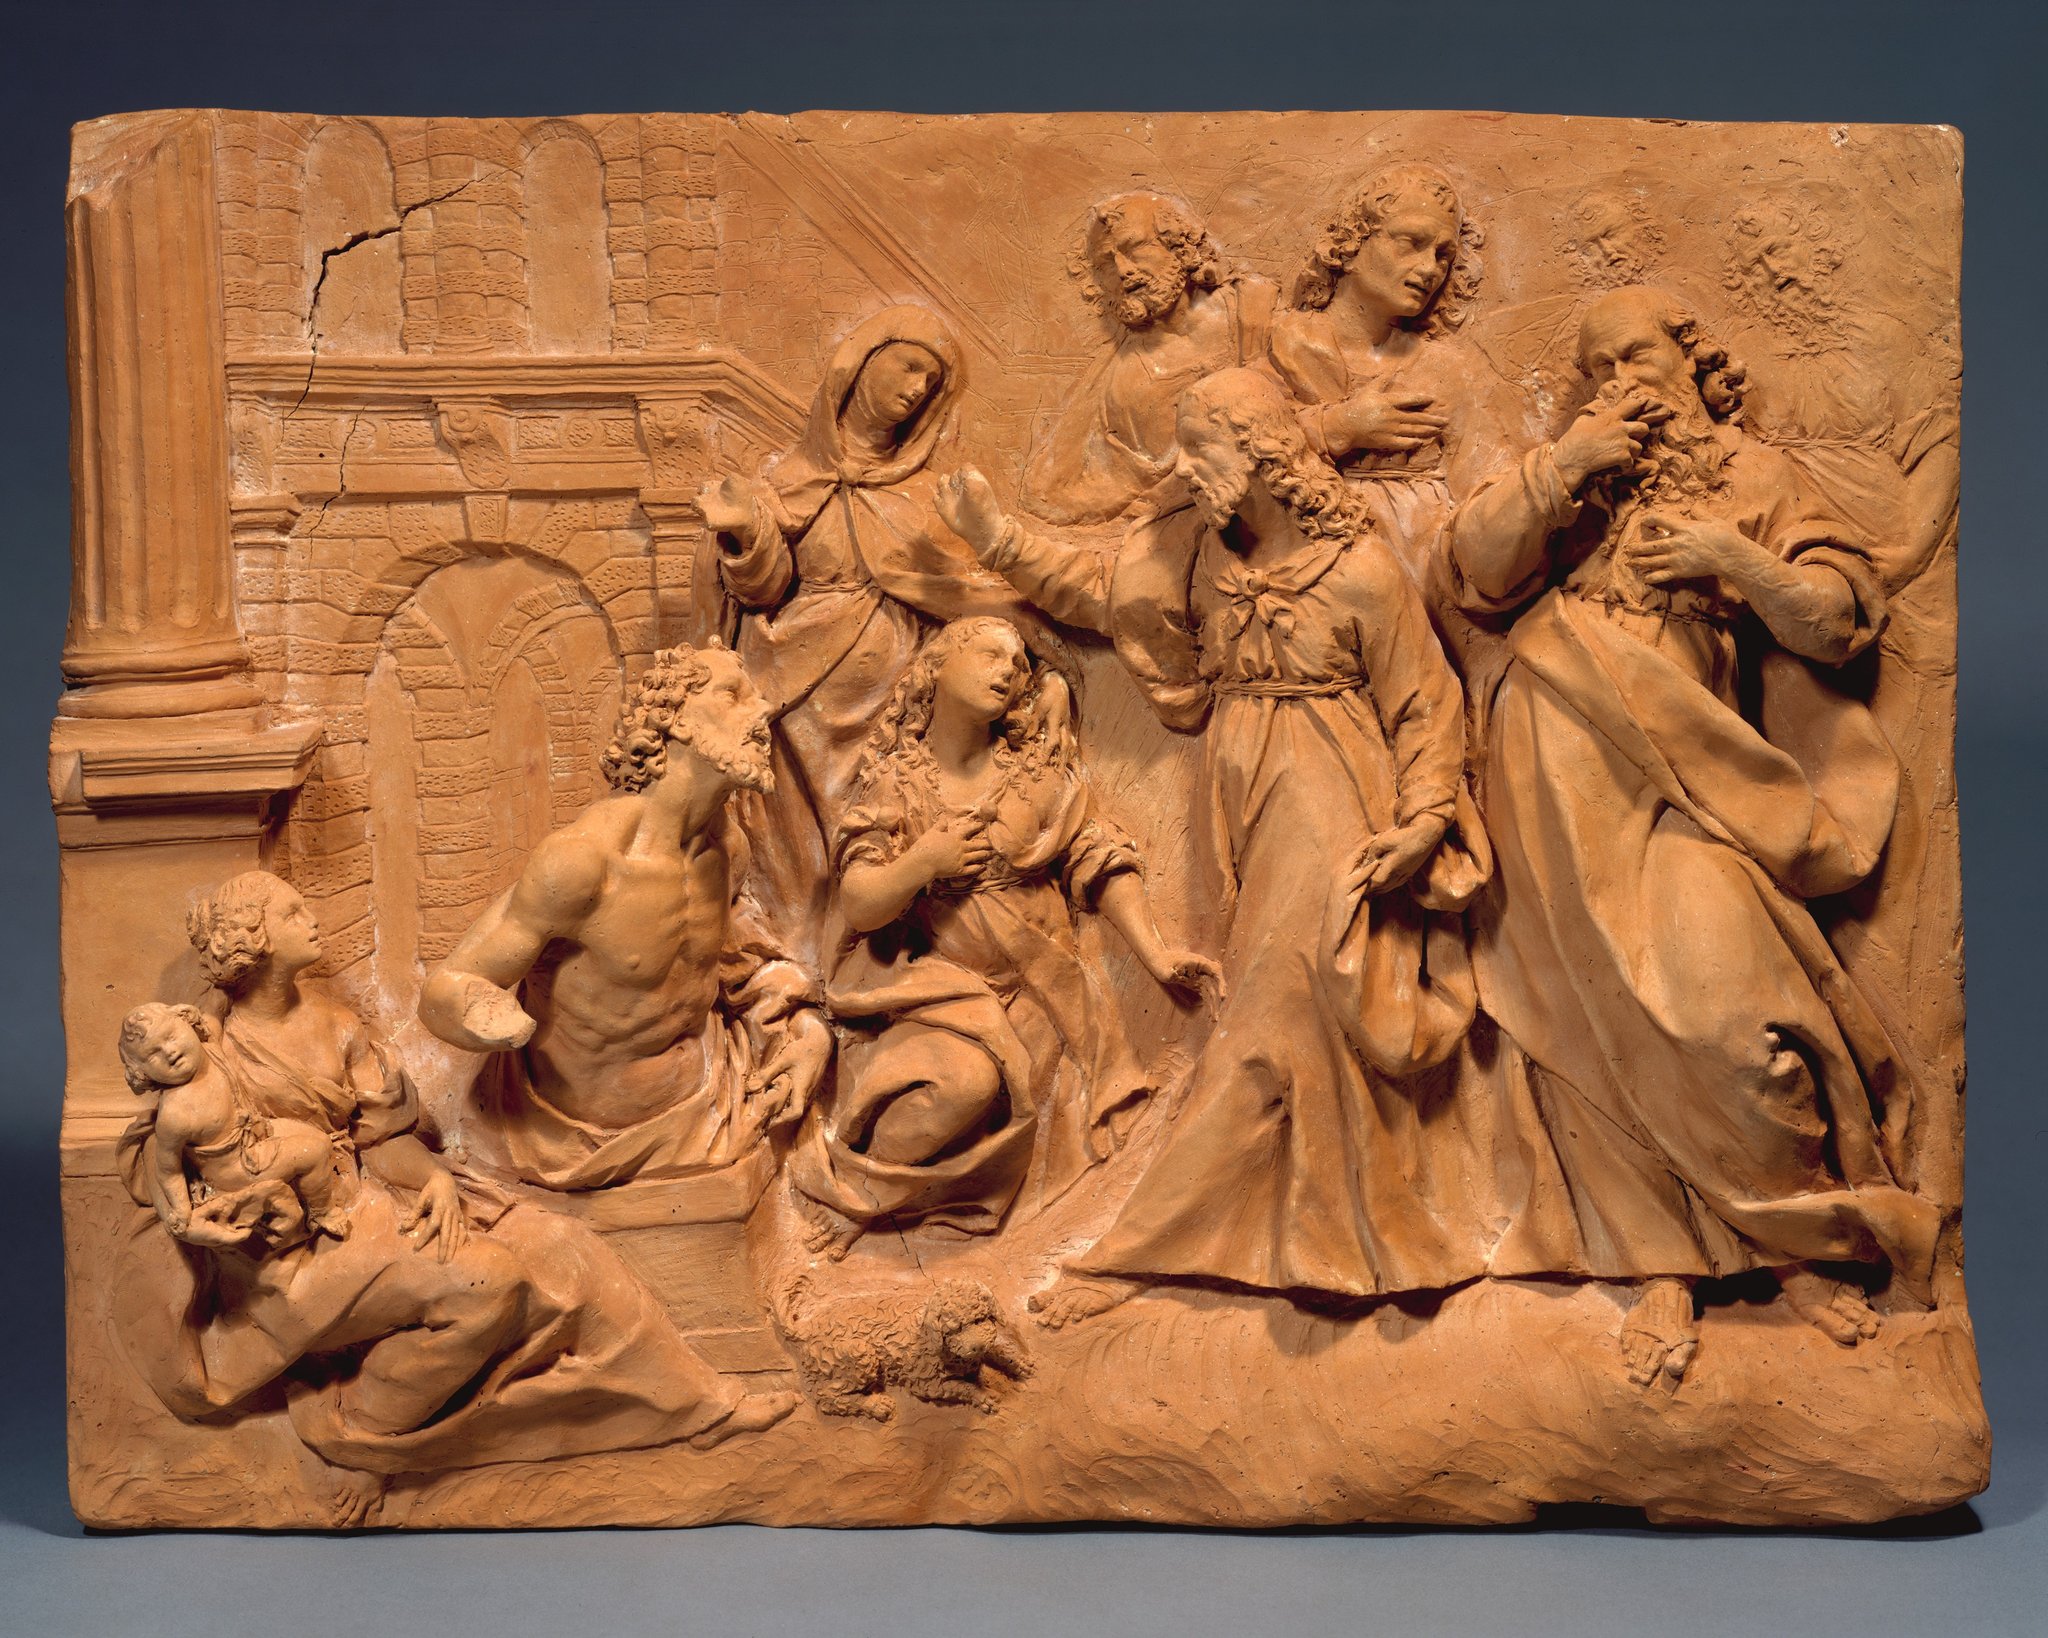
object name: relief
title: The Raising of Lazarus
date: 1620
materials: terracotta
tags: infants,men,women,jesus